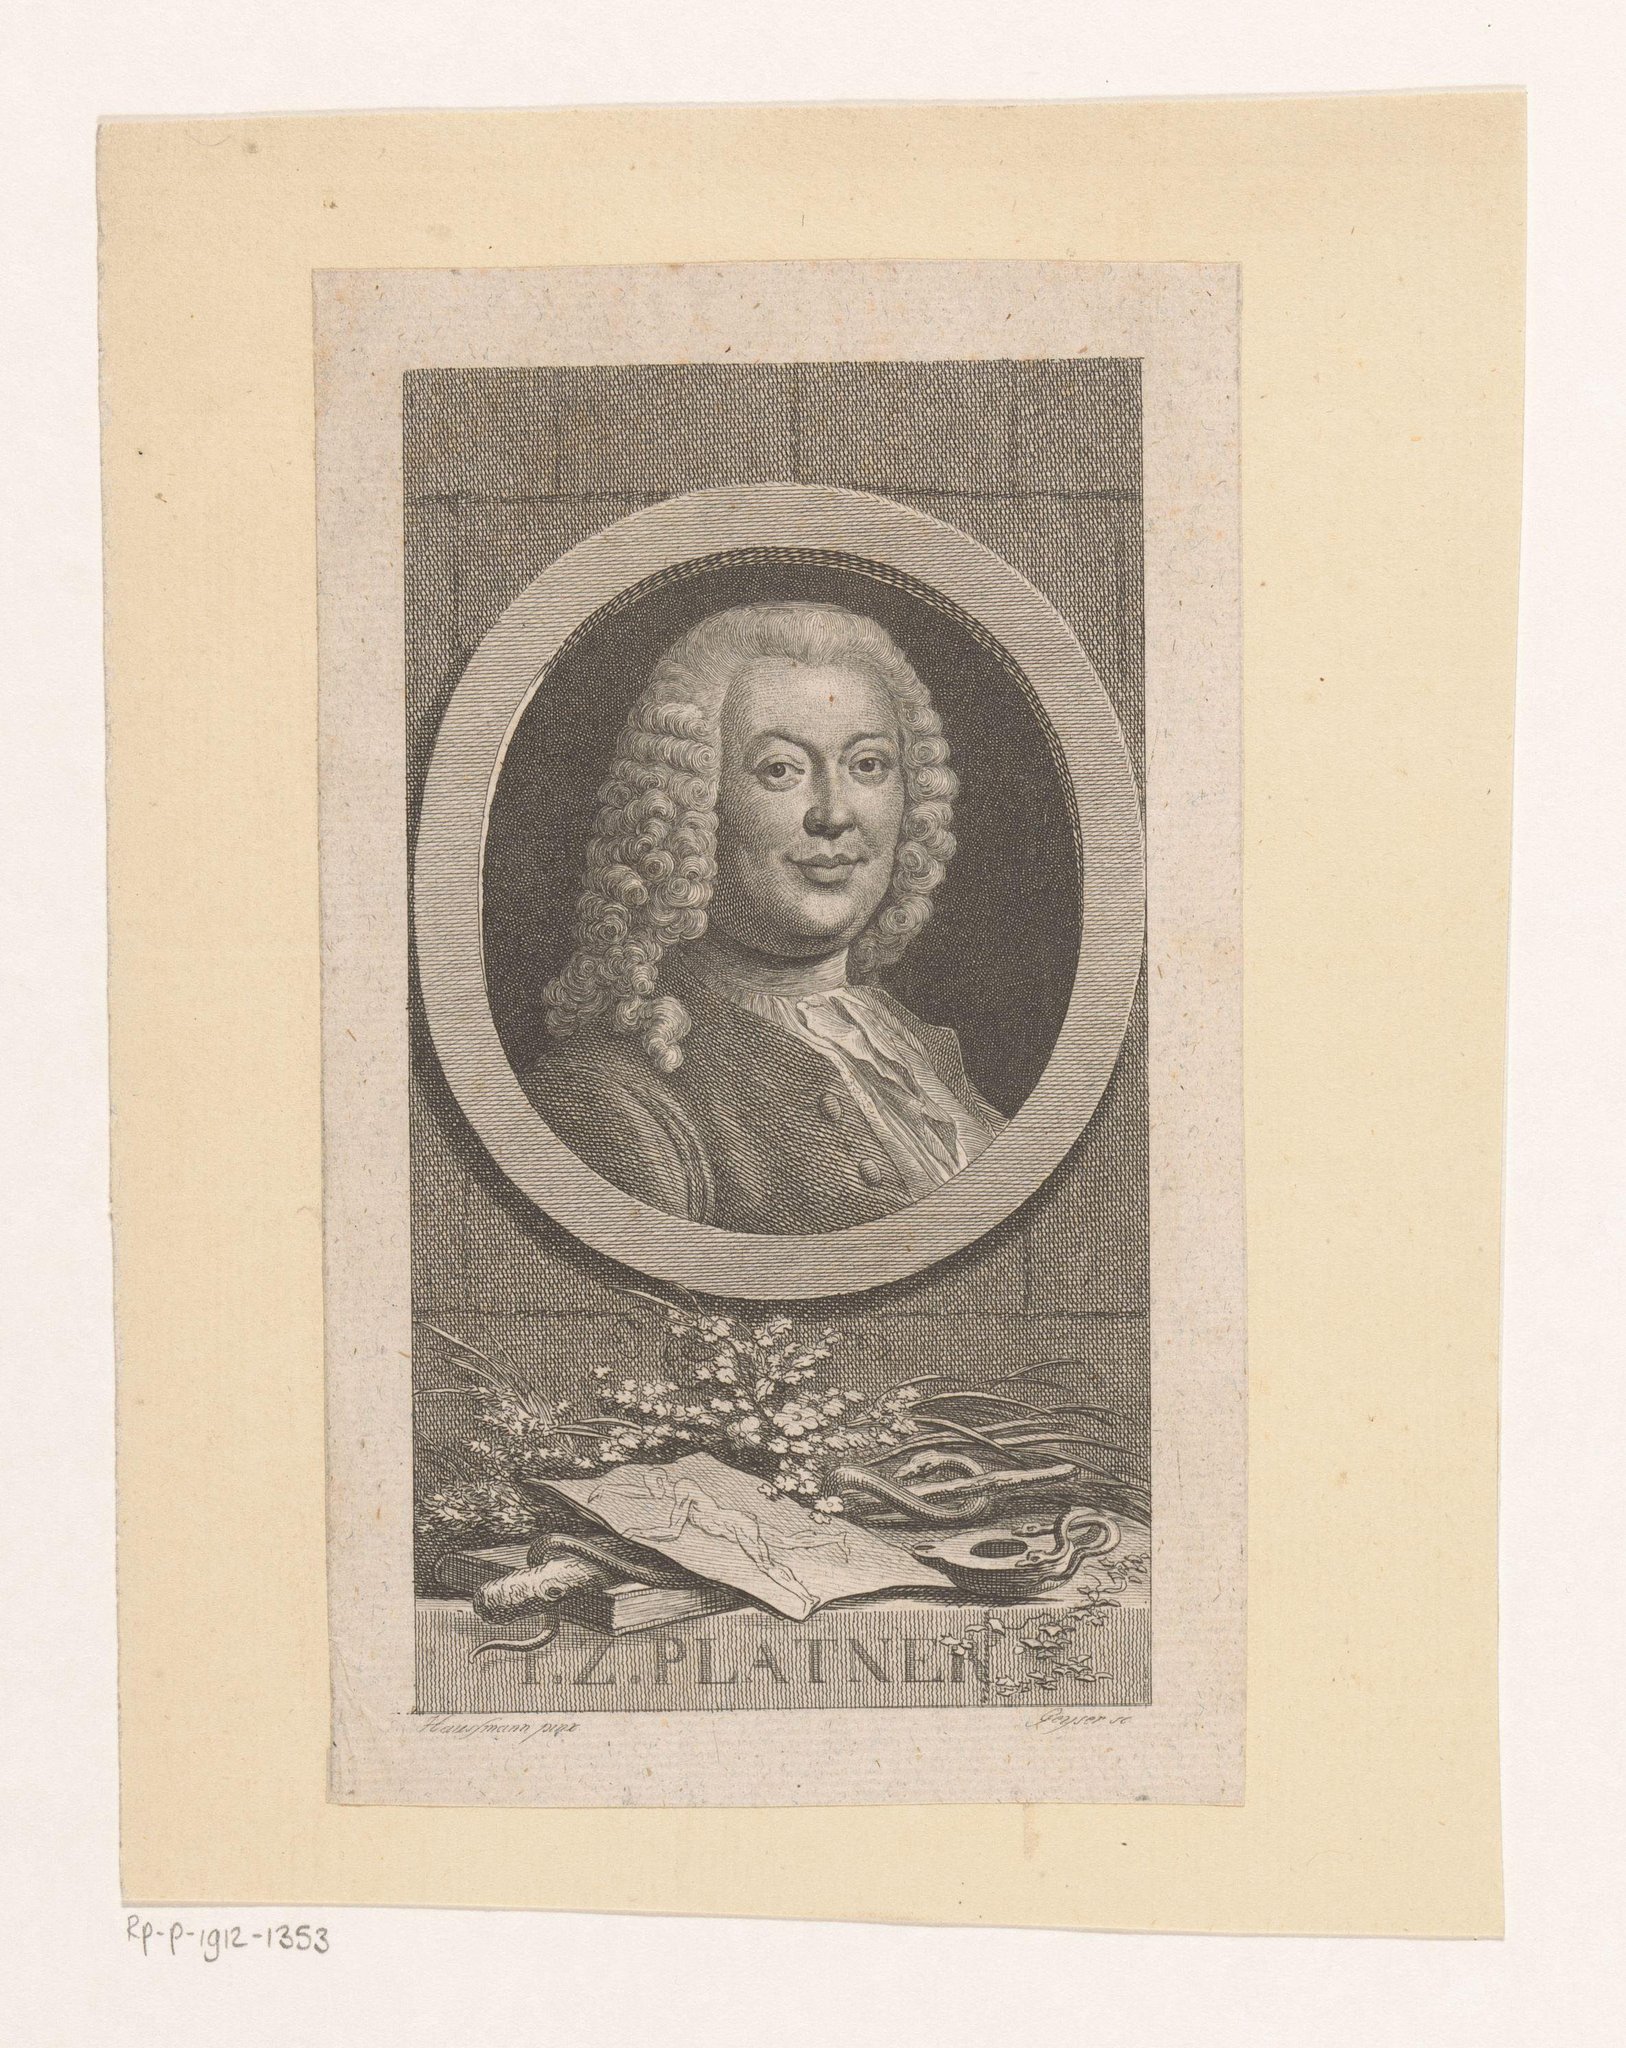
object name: print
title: Portret van Johann Zacharias Platner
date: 1752-1803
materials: paper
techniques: engraving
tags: chemnitz, attributes of aesculapius: rod and serpent, historical persons, physiology and anatomy, physician, doctor, oil-lamp